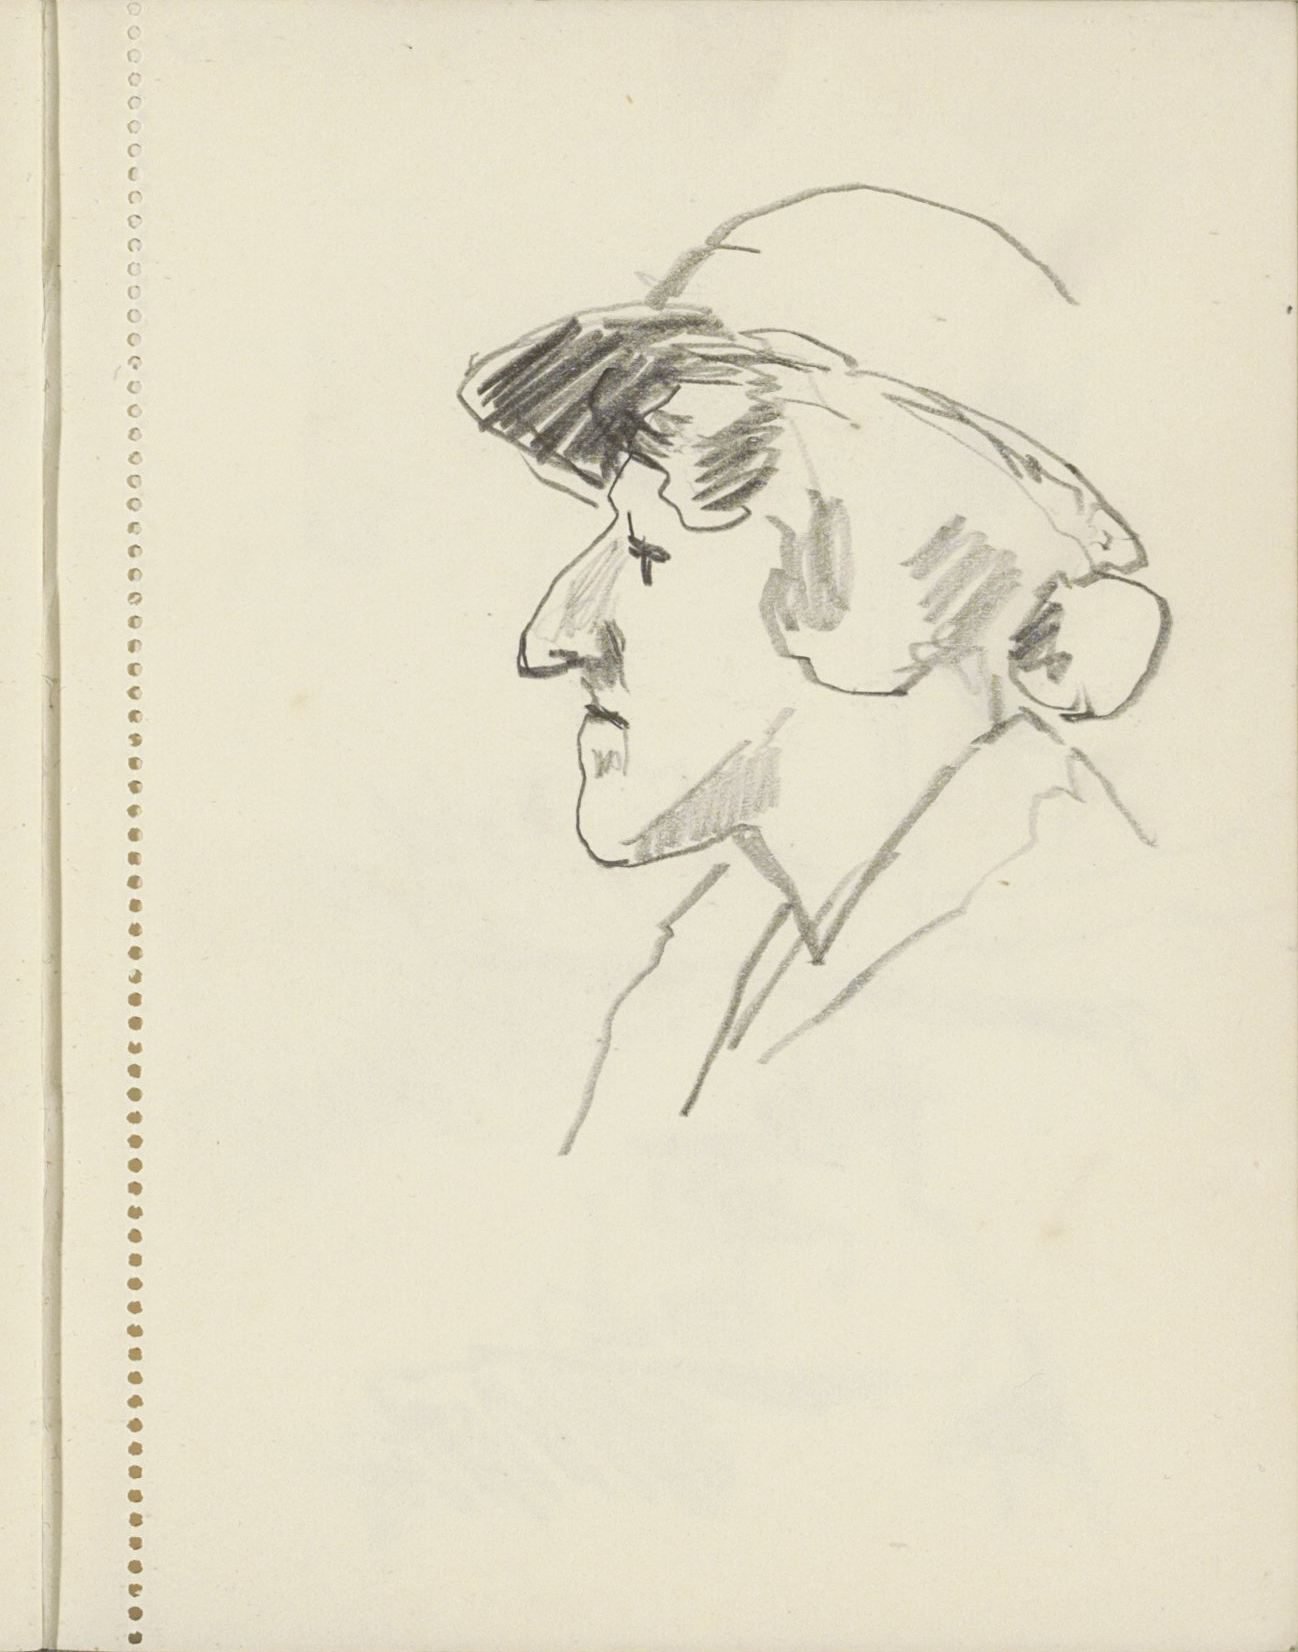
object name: sketchbook leaf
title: Kop van een vrouw met een hoed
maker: cornelis vreedenburgh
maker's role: draughtsman, print maker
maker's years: 1880-1946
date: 1890-1946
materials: paper, pencil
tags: head-gear: hat (+ women's clothes), head (human) - aa - female human figure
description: Blad 24 recto uit een schetsboek met 71 bladen.